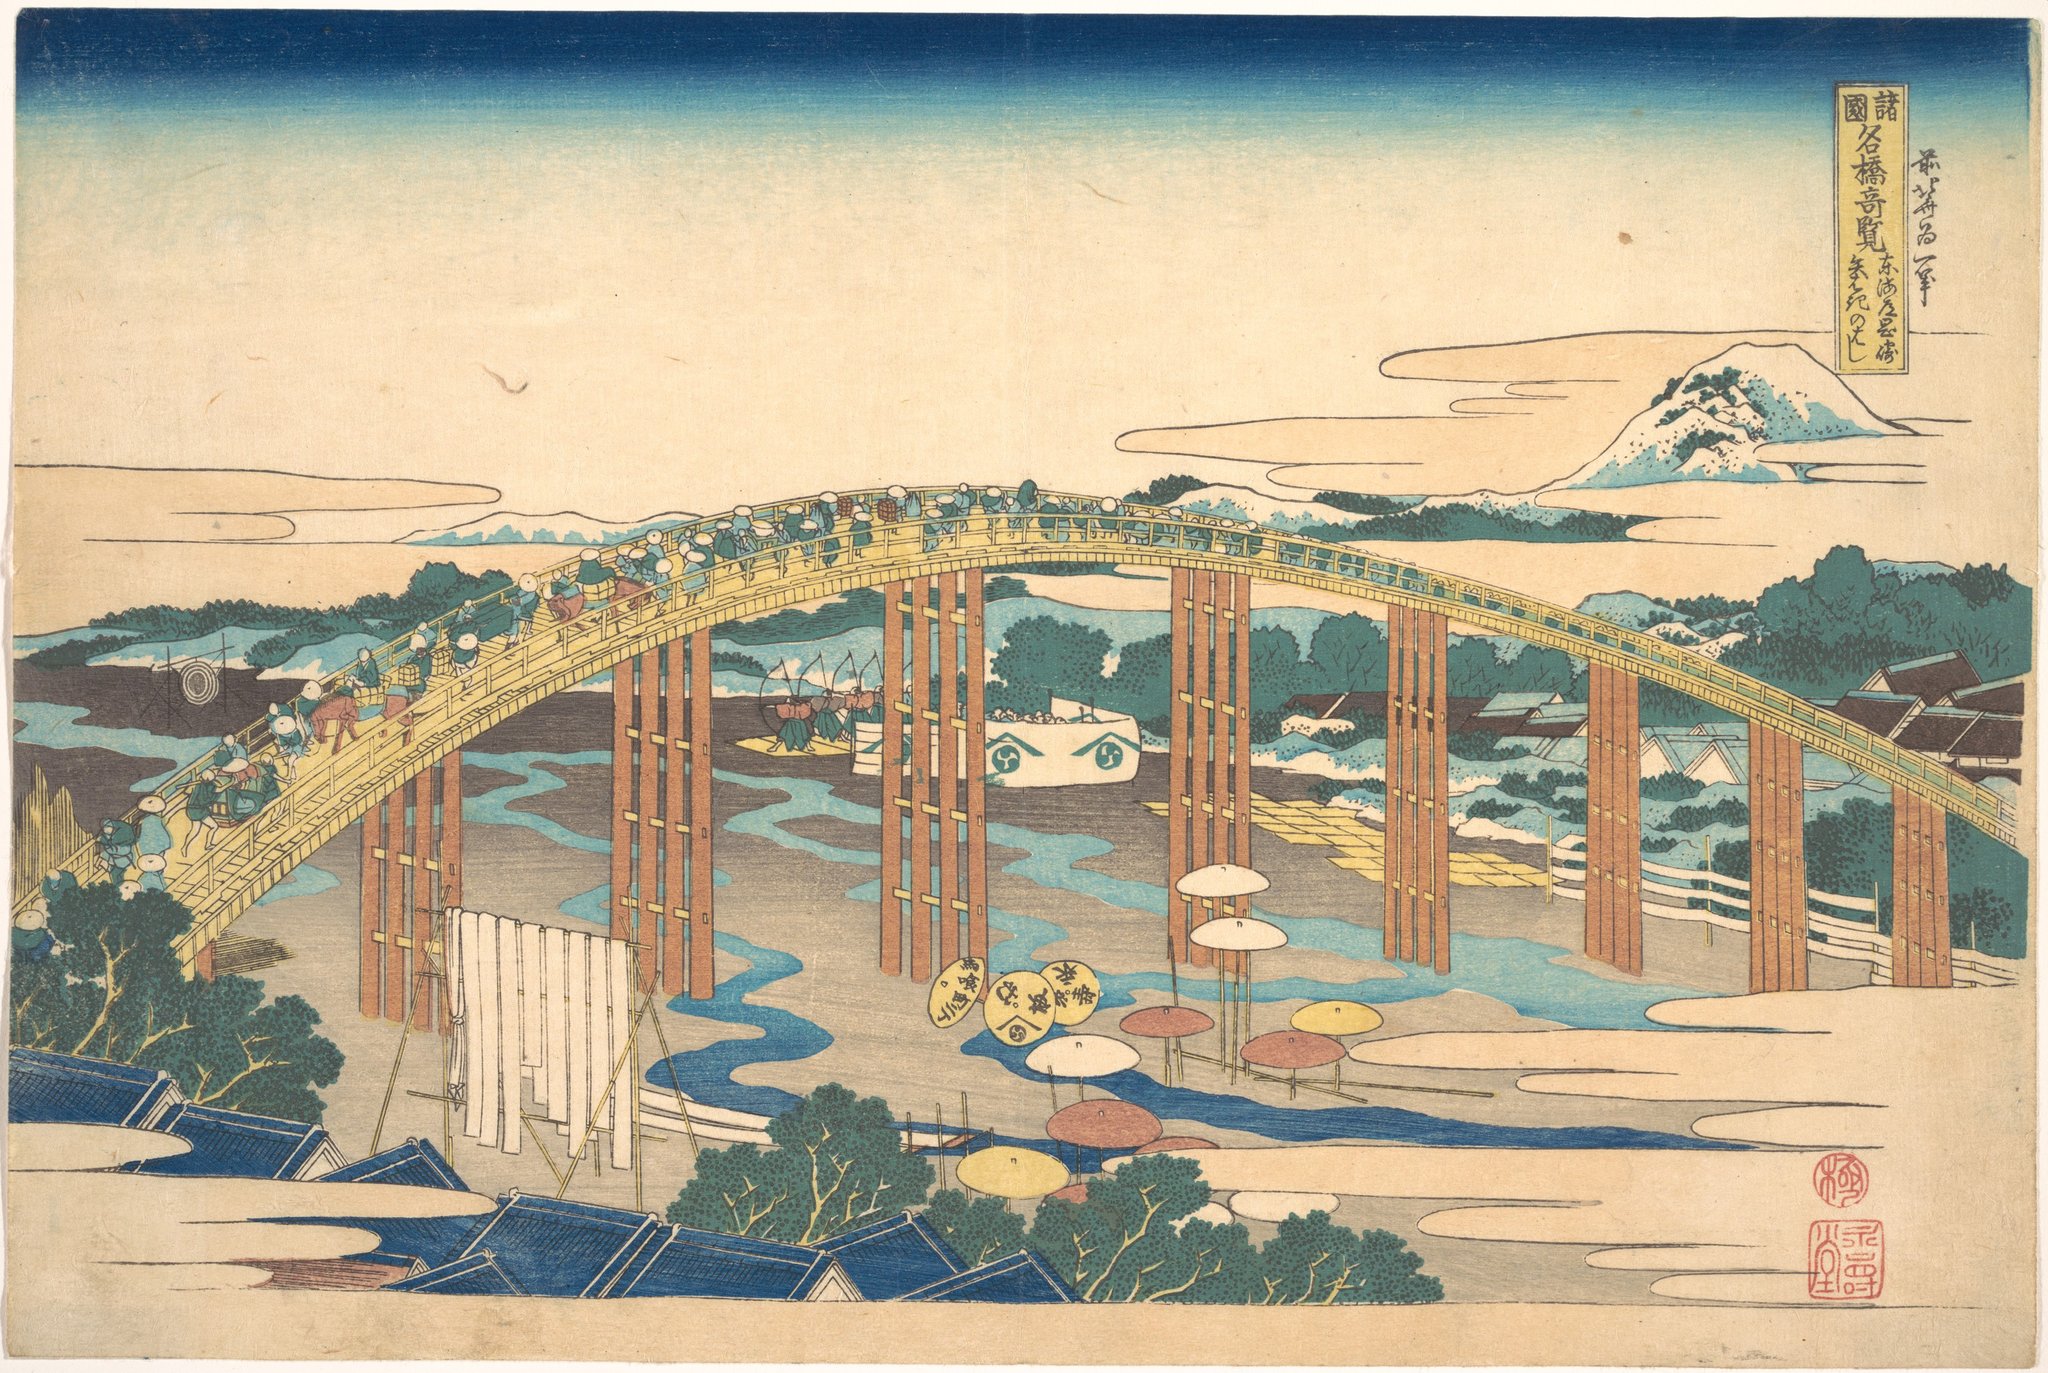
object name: woodblock print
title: Yahagi Bridge at Okazaki on the Tōkaidō (Tōkaidō Okazaki Yahagi no hashi), from the series Remarkable Views of Bridges in Various Provinces (Shokoku meikyō kiran)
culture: japanese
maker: katsushika hokusai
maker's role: artist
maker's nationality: japanese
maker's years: 1760-1849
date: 1830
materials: ink, paper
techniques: woodblock print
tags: human figures,bridges,landscapes,trees